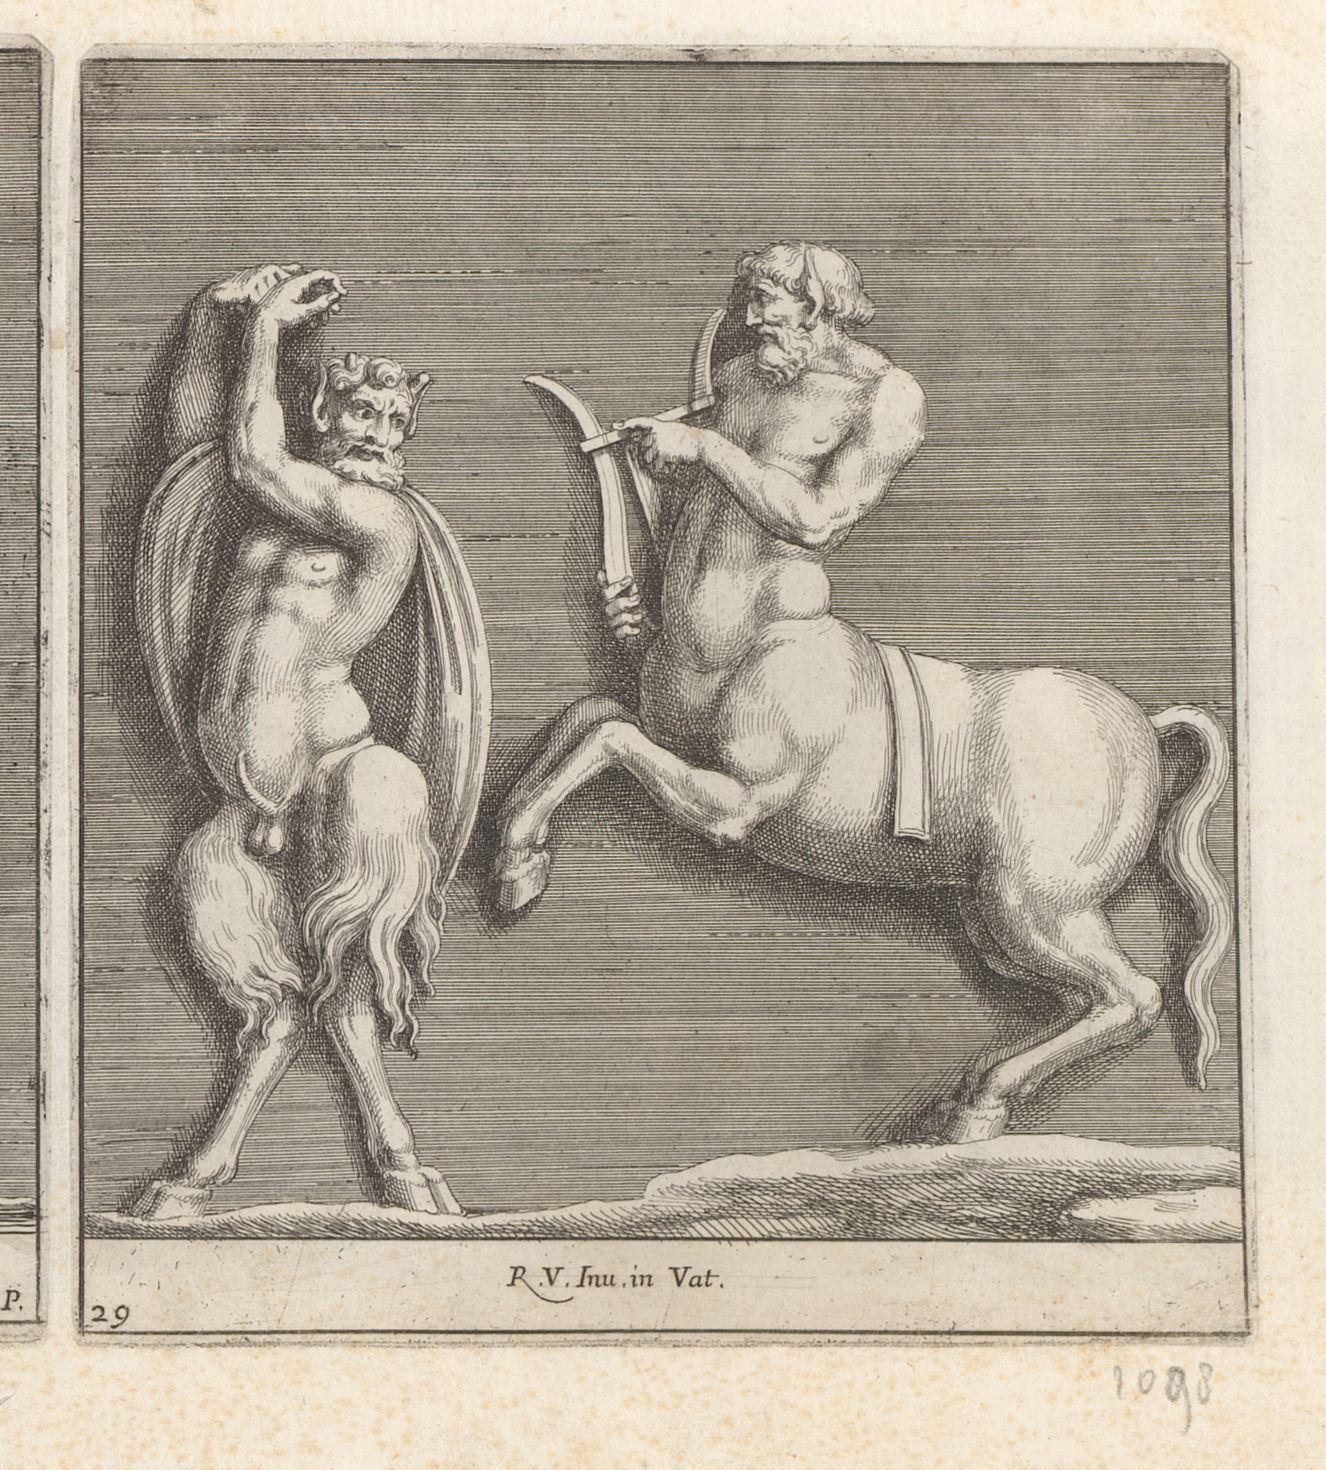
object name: album leaf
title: Sater en een centaur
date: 1645-1700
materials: paper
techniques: engraving, etching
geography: italy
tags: centaurs, satyr(s) (in general)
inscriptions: number: ‘13’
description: Prent uit een reeks naar de gipsen reliëfs door Rafaël en uitgevoerd door zijn assistenten in de Vaticaanse Loggia.